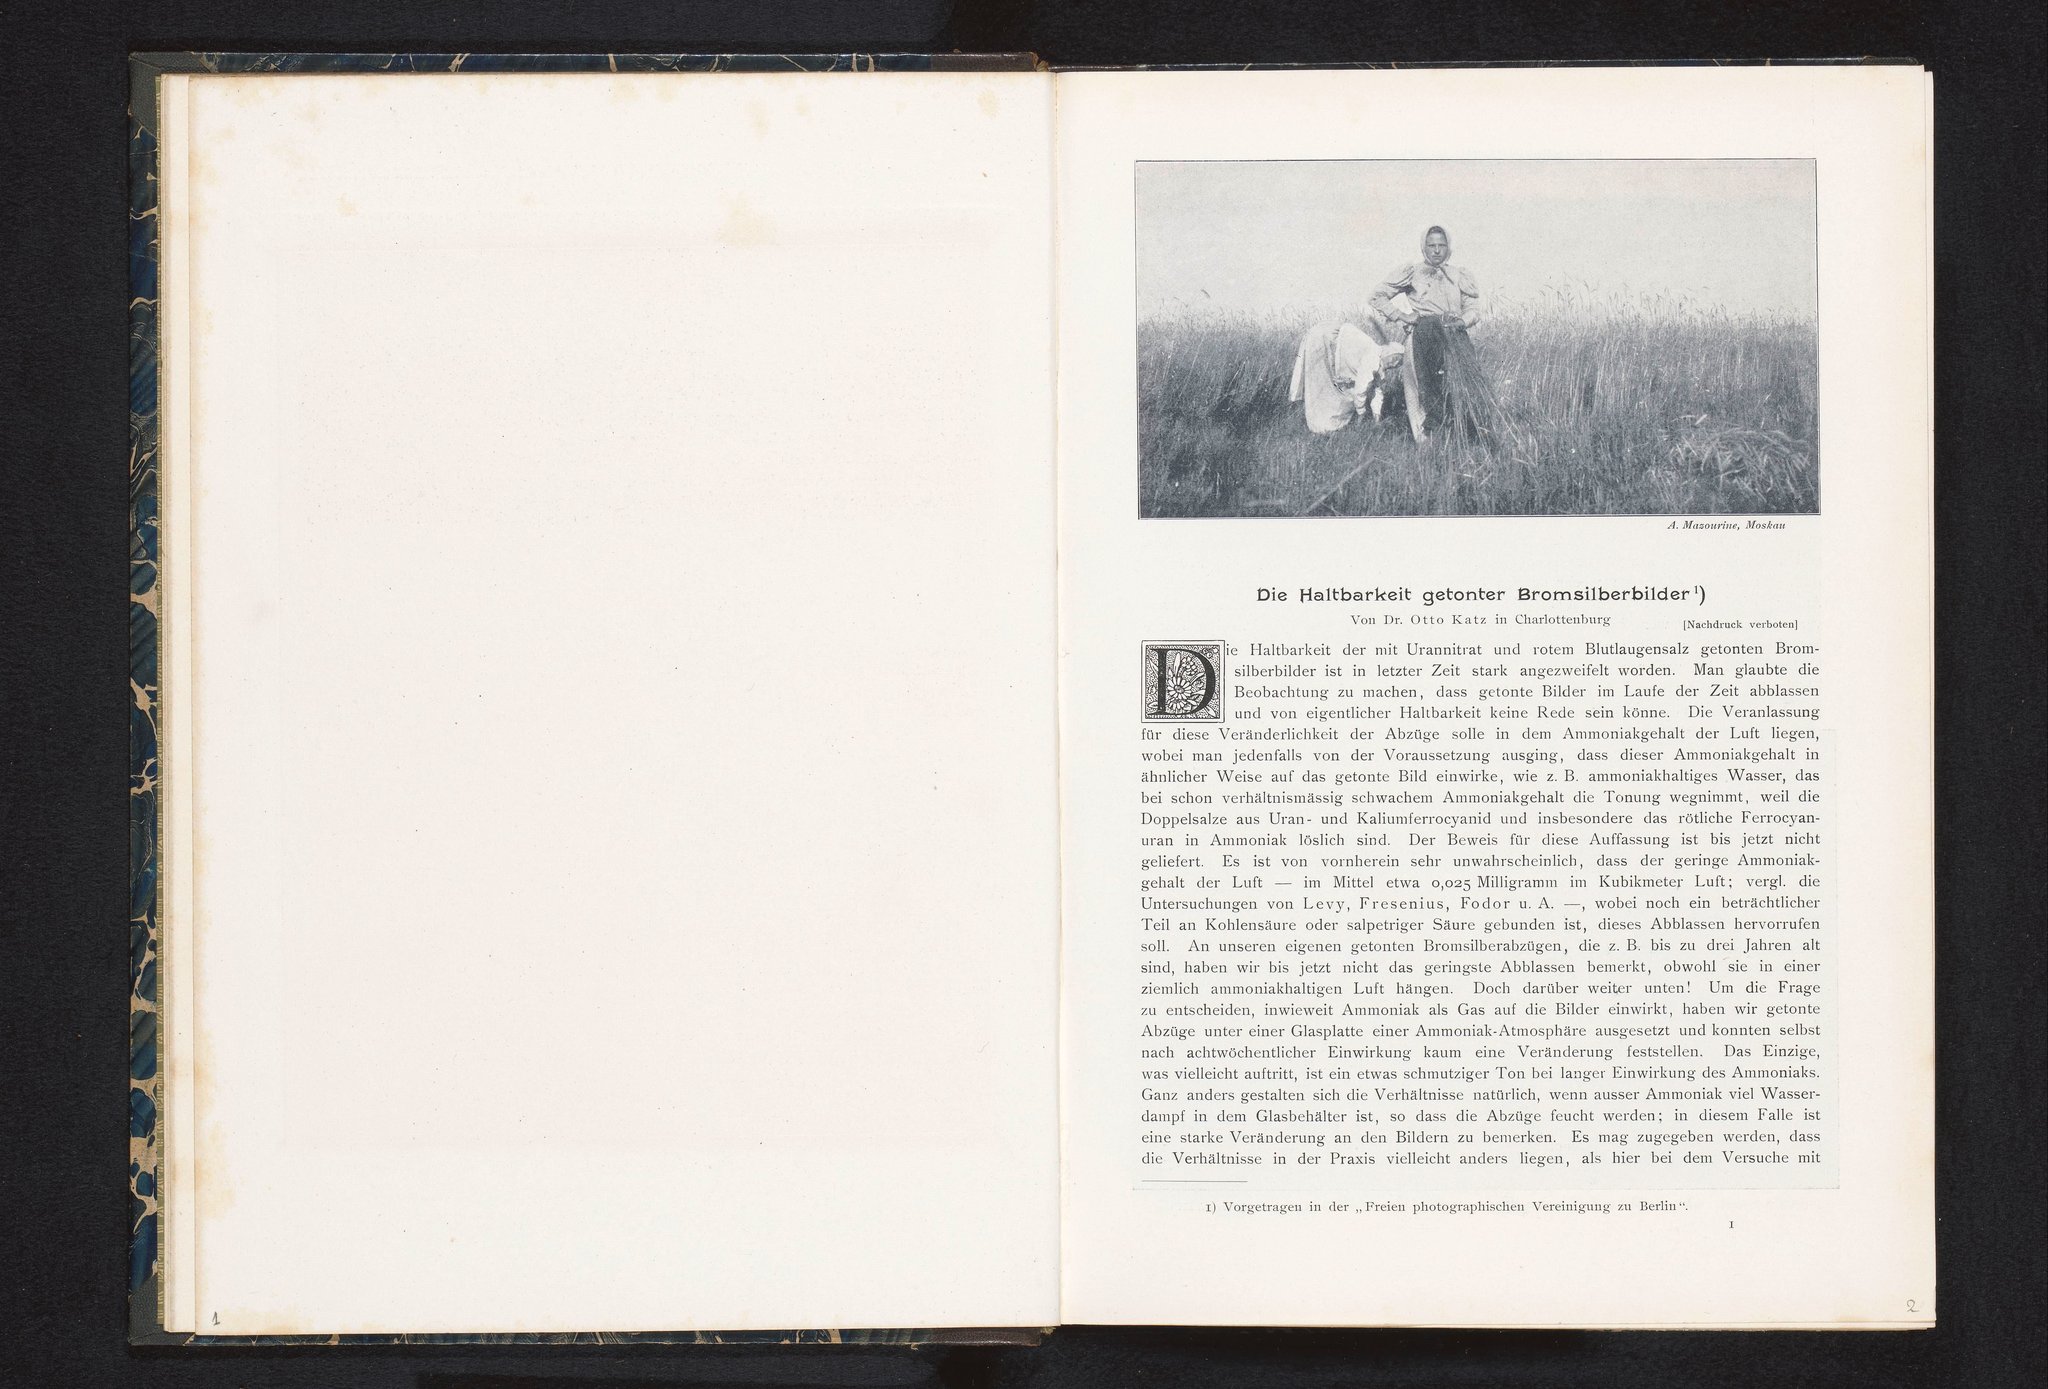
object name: page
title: Twee vrouwen aan het werk op het land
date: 1896-1901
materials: paper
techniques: autotype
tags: cultivation ~ agriculture (+ women (labourers))